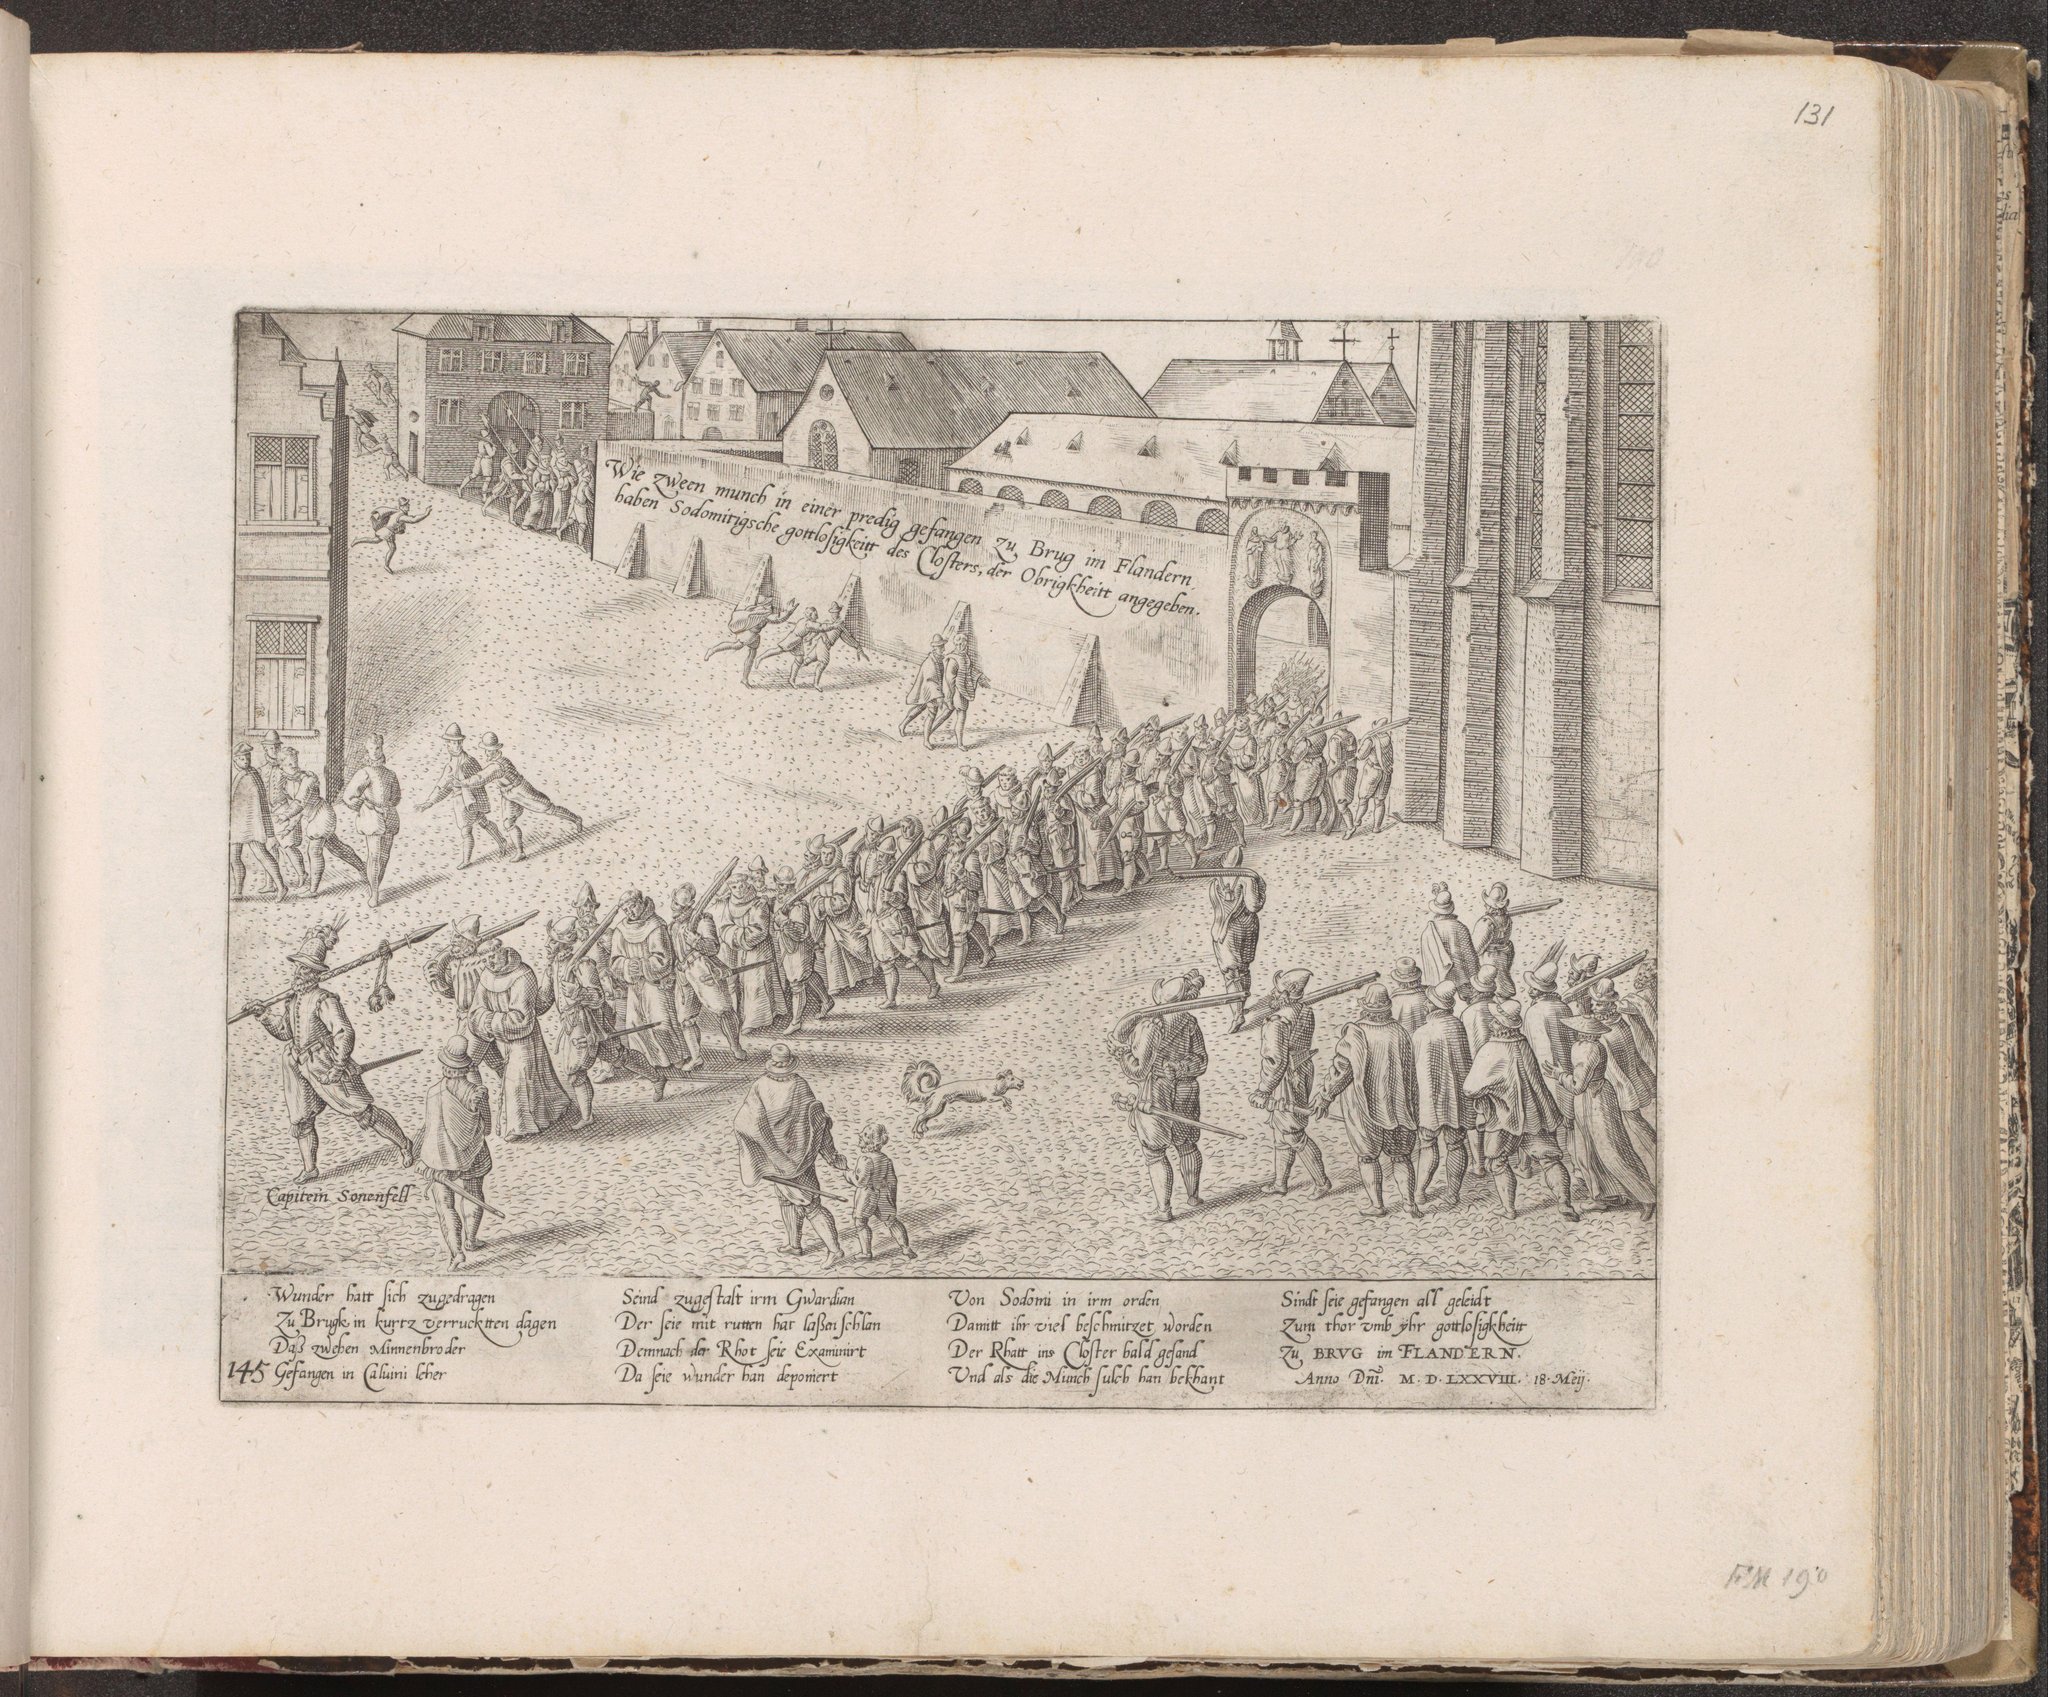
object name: album leaf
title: Wie zween munch in einer predig gefangen zu Brug im Flandern haben Sodomitigsche gottlosigkeitt des Closters, der Obrigkeitt angegeben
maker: frans hogenberg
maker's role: print maker, publisher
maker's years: 1538-1590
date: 1581-1585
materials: paper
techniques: etching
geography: cologne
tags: bruges, sodomy, sexual contact between men, monk(s), friar(s)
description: Arrestatie van de Franciscaner monniken in een klooster te Brugge op beschuldiging van sodomie, 18 mei 1578. Onder begeleiding van soldaten worden de monniken uit het klooster afgevoerd. Onder hen de beruchte Broer Cornelis van Dordrecht. Met onderschrift van 15 regels in het Duits. Linksonder genummerd: 145. De prent maakt deel uit van een album.